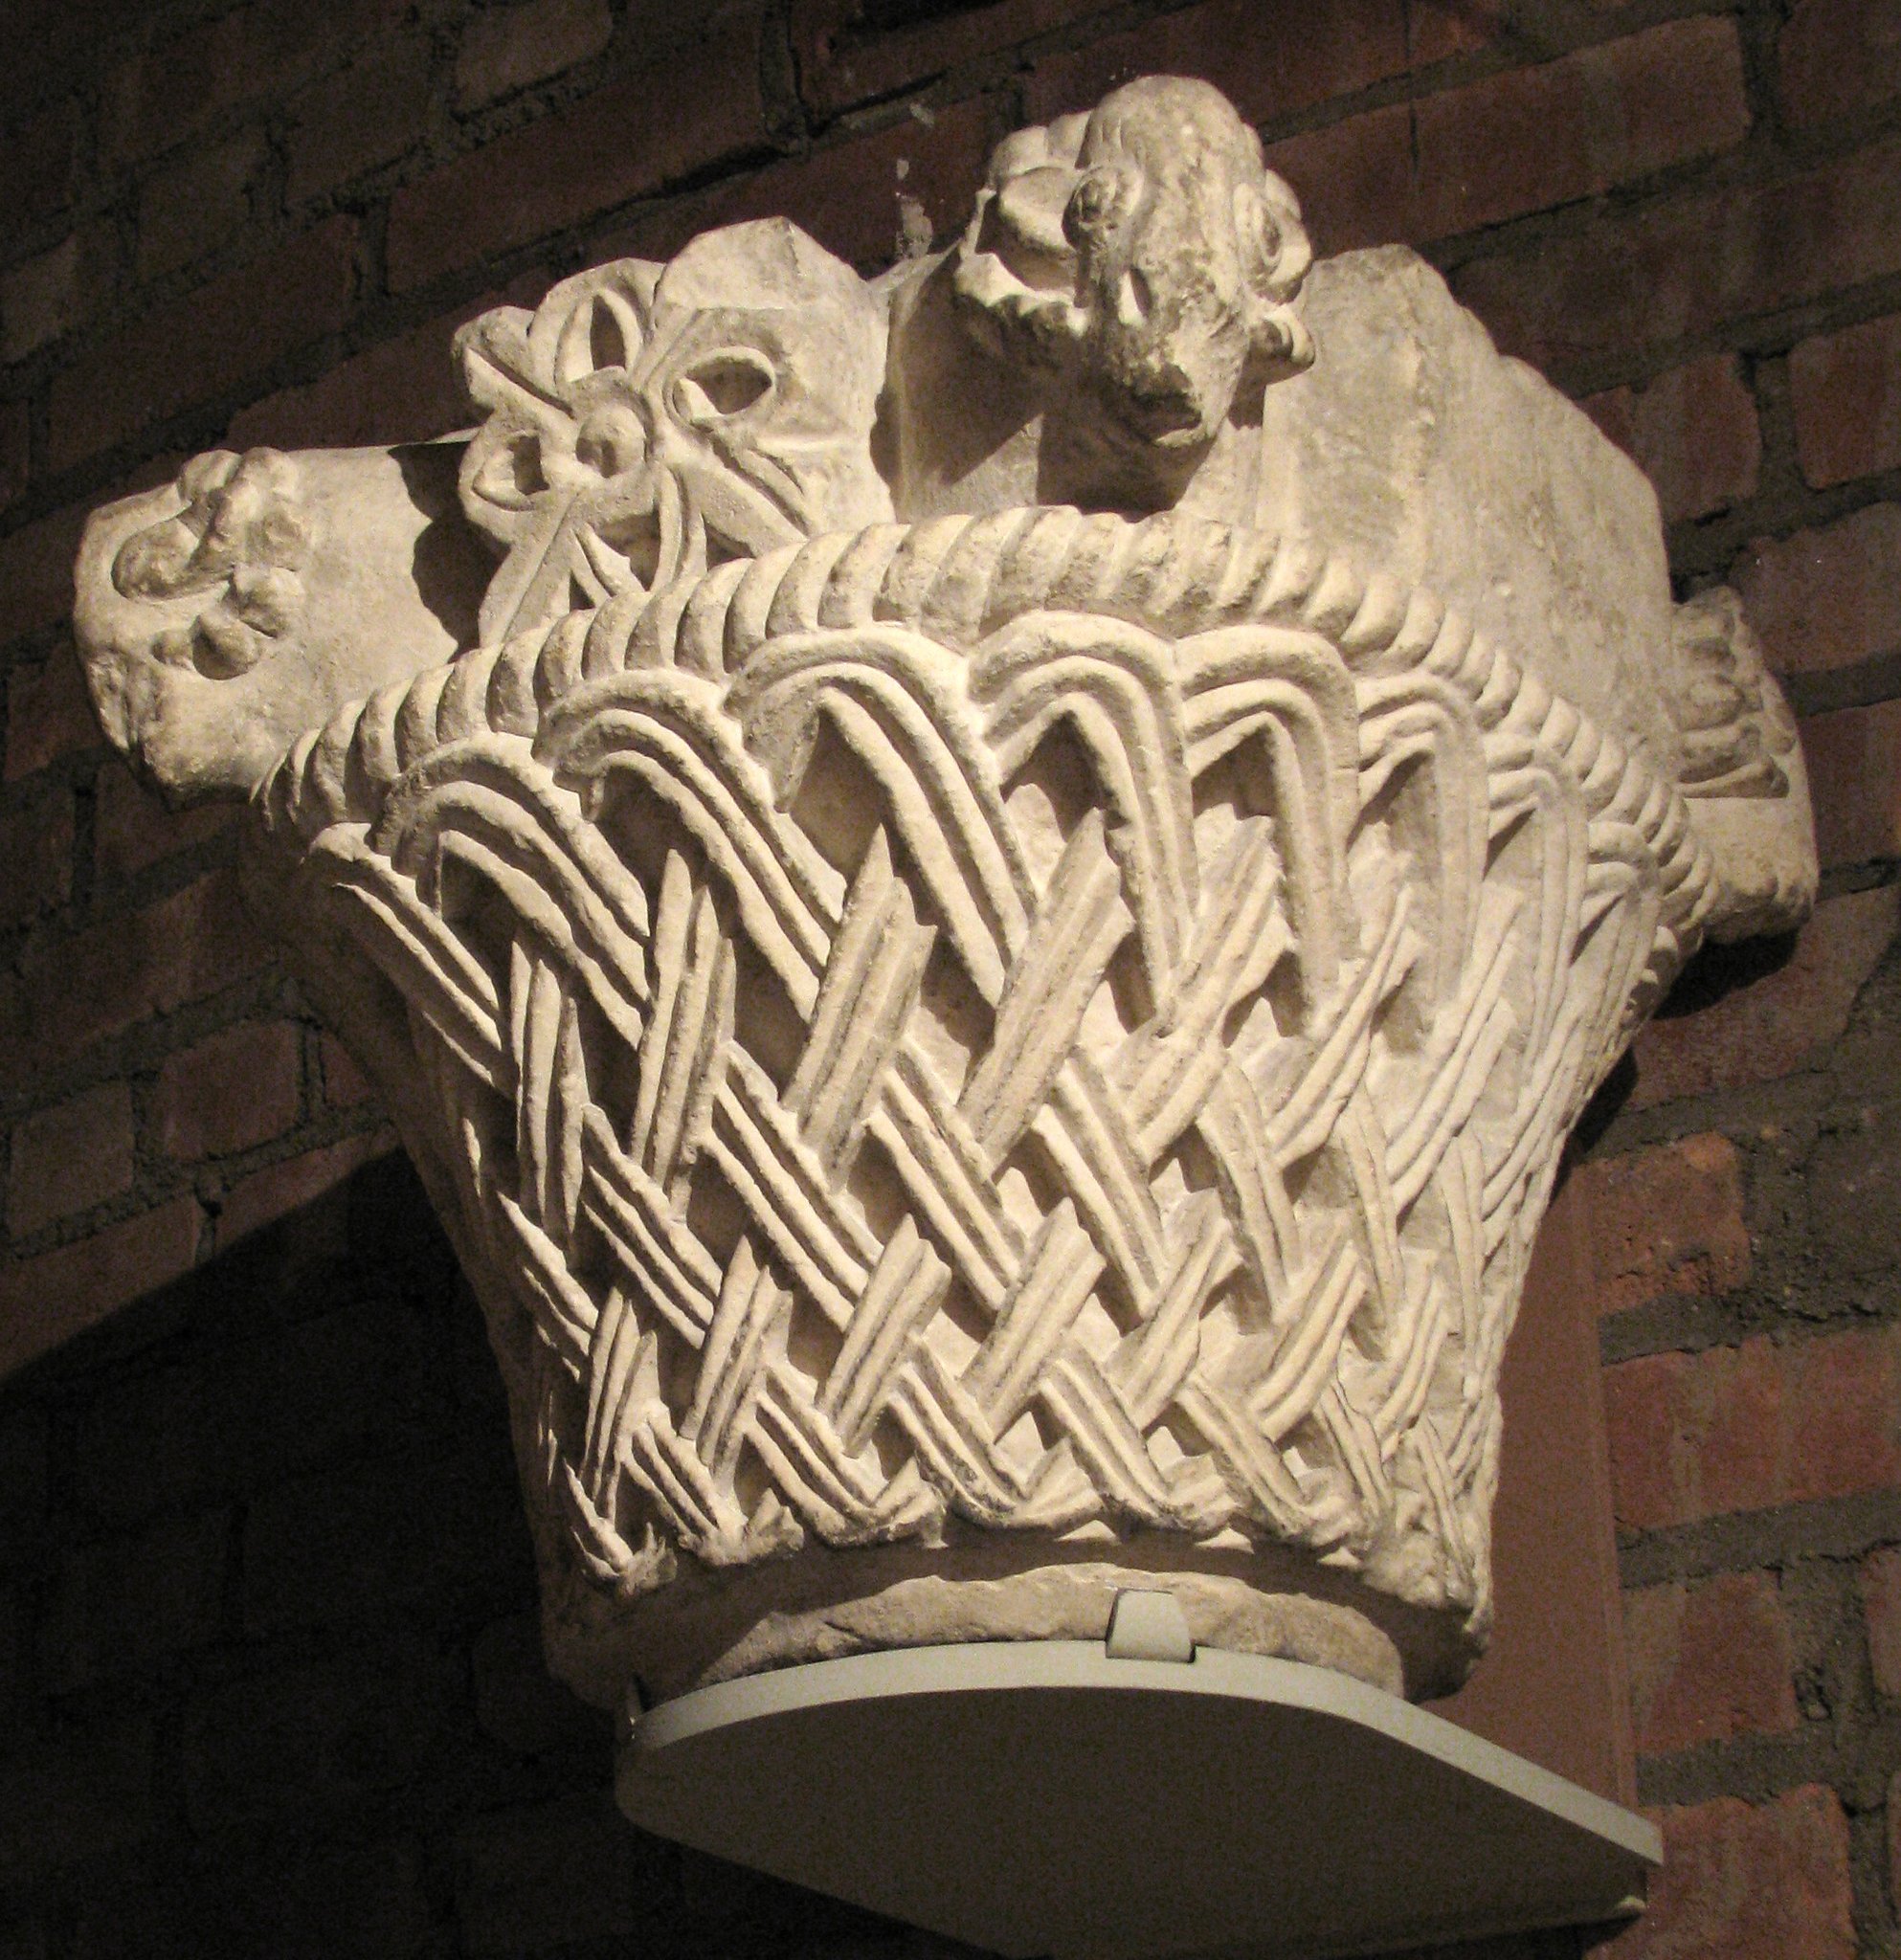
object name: capital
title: Capital with a Basket-Weave Pattern and Rams’ Heads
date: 401-600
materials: limestone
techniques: carving, relief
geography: egypt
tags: rams